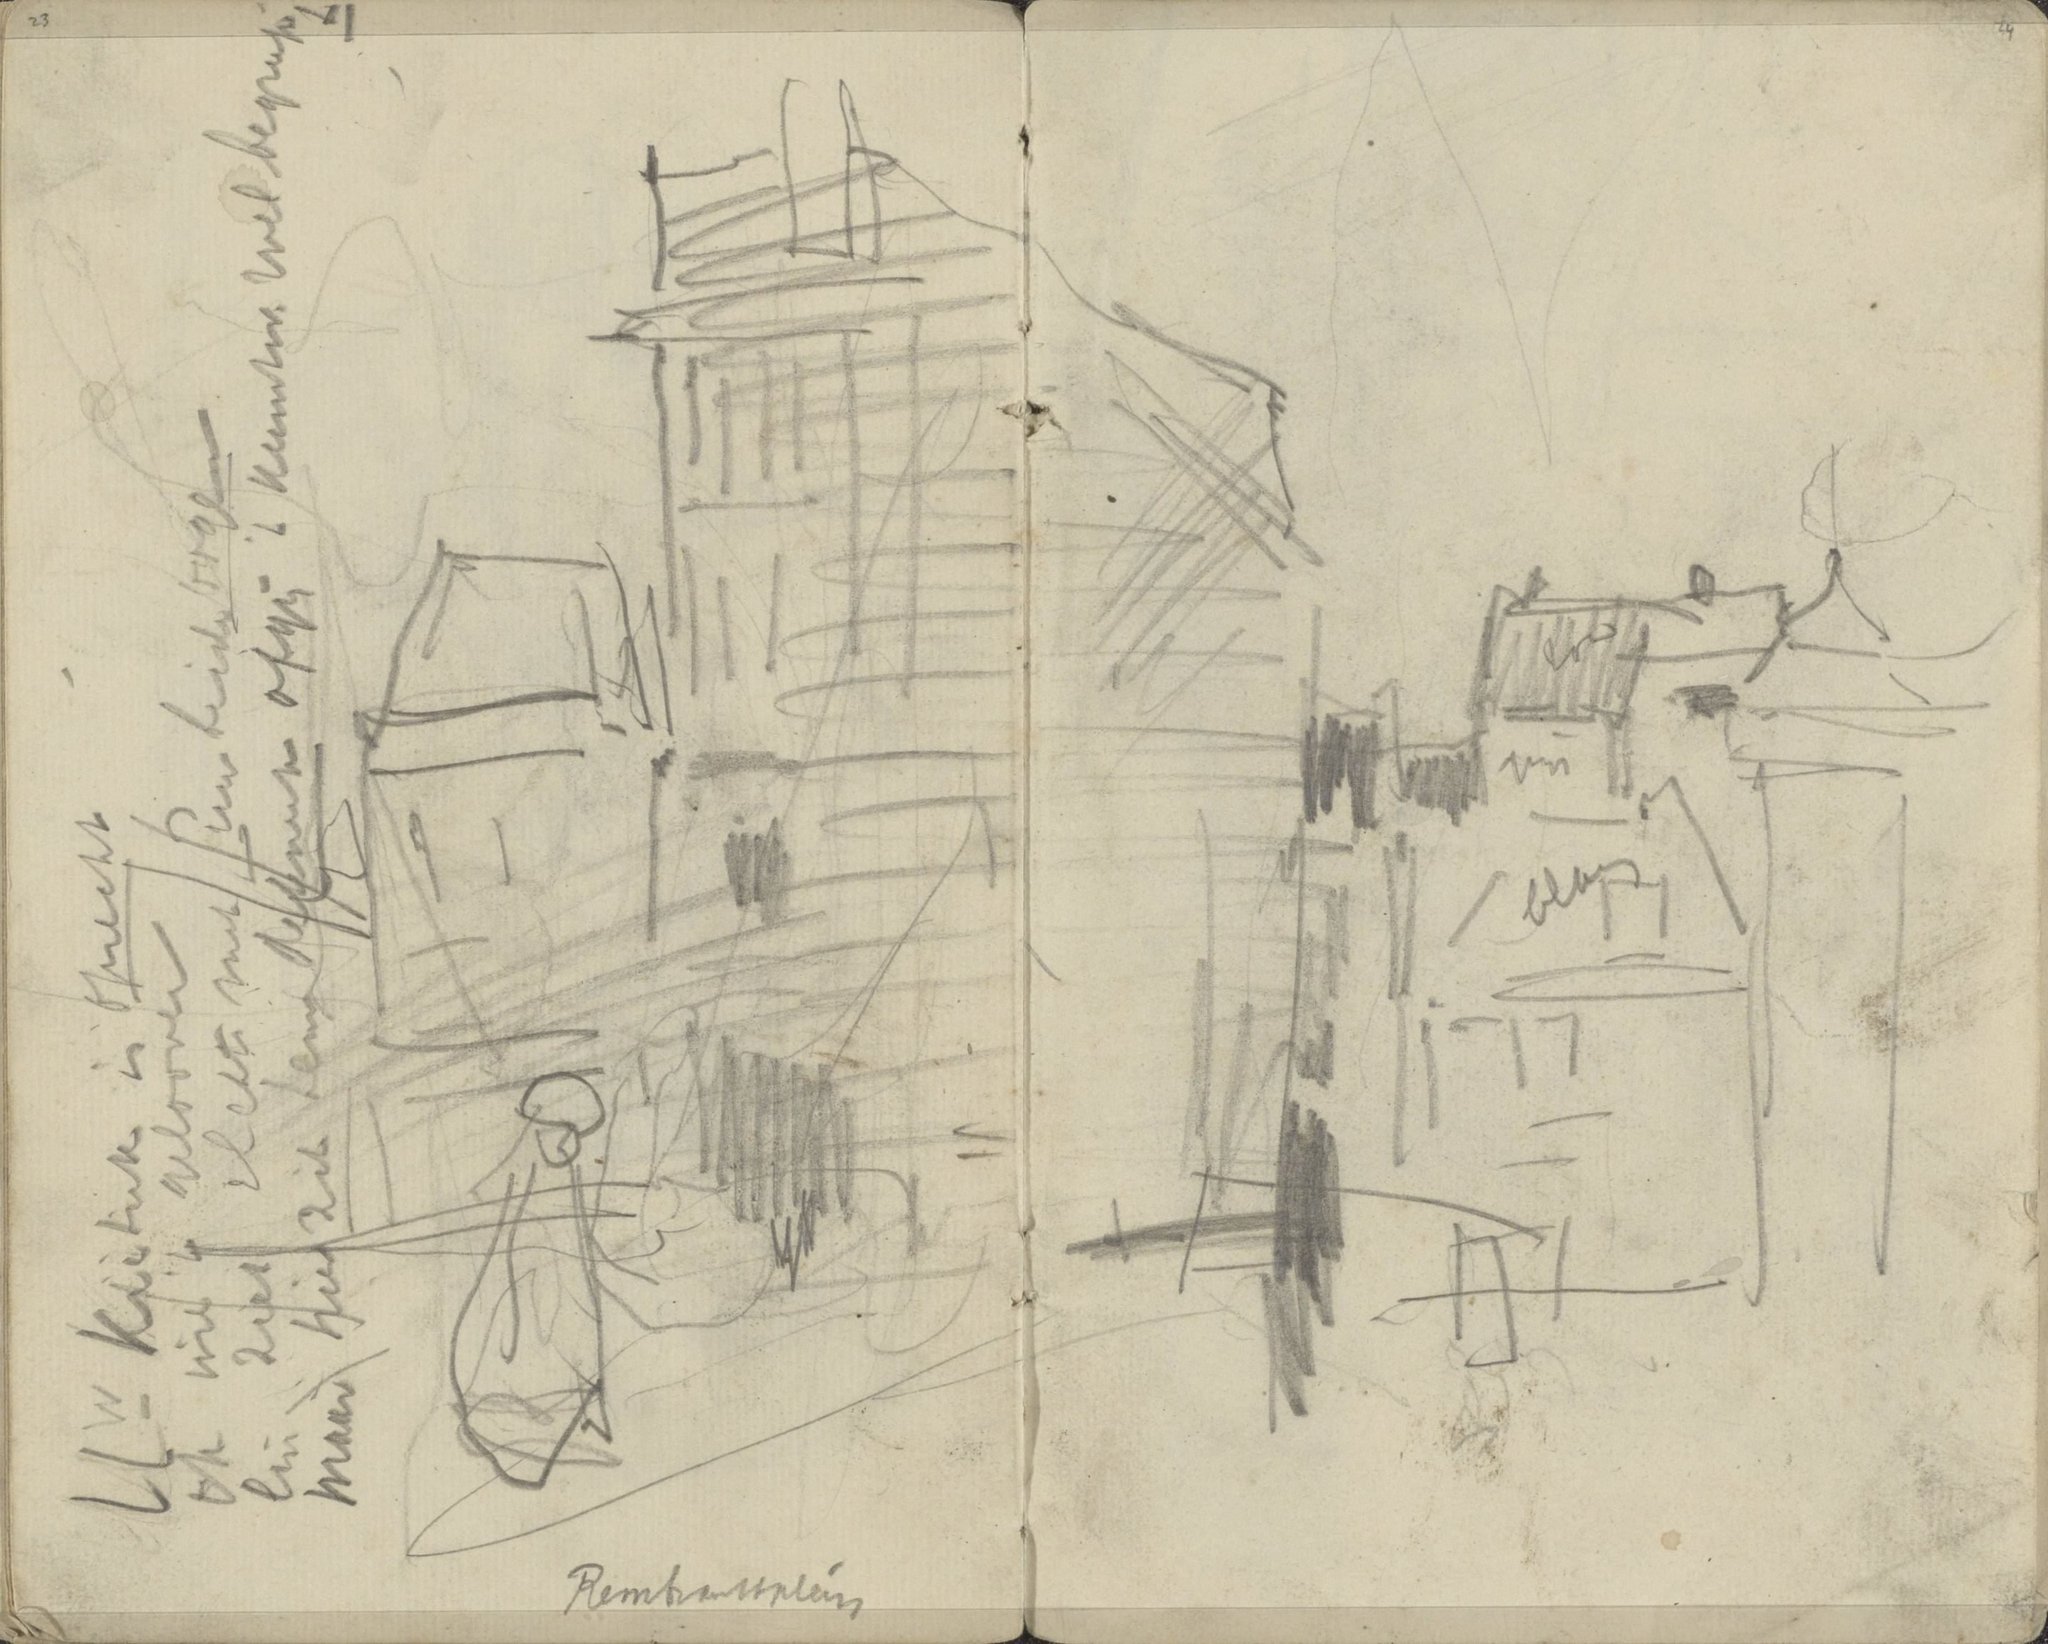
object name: sketchbook leaf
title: Gezicht op het Rembrandtplein te Amsterdam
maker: george hendrik breitner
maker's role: draughtsman, painter, print maker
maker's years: 1857-1923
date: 1883-1885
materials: paper, pencil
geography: amsterdam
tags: square, place, circus, etc. (+ city(-scape) with figures, staffage)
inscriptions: annotation: ‘[...] is oprecht/ [...]/ Eén ziet slecht met [...] beide oogen/ maar hier zit [...]’, annotation: ‘Rembrandtplein’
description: Pagina 23 en pagina 24 uit een schetsboek met 16 bladen.